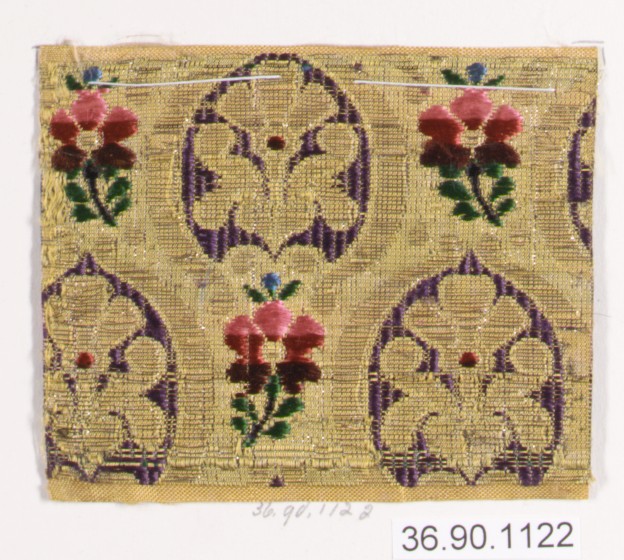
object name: sample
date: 1701-1900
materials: metal thread, silk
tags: flowers